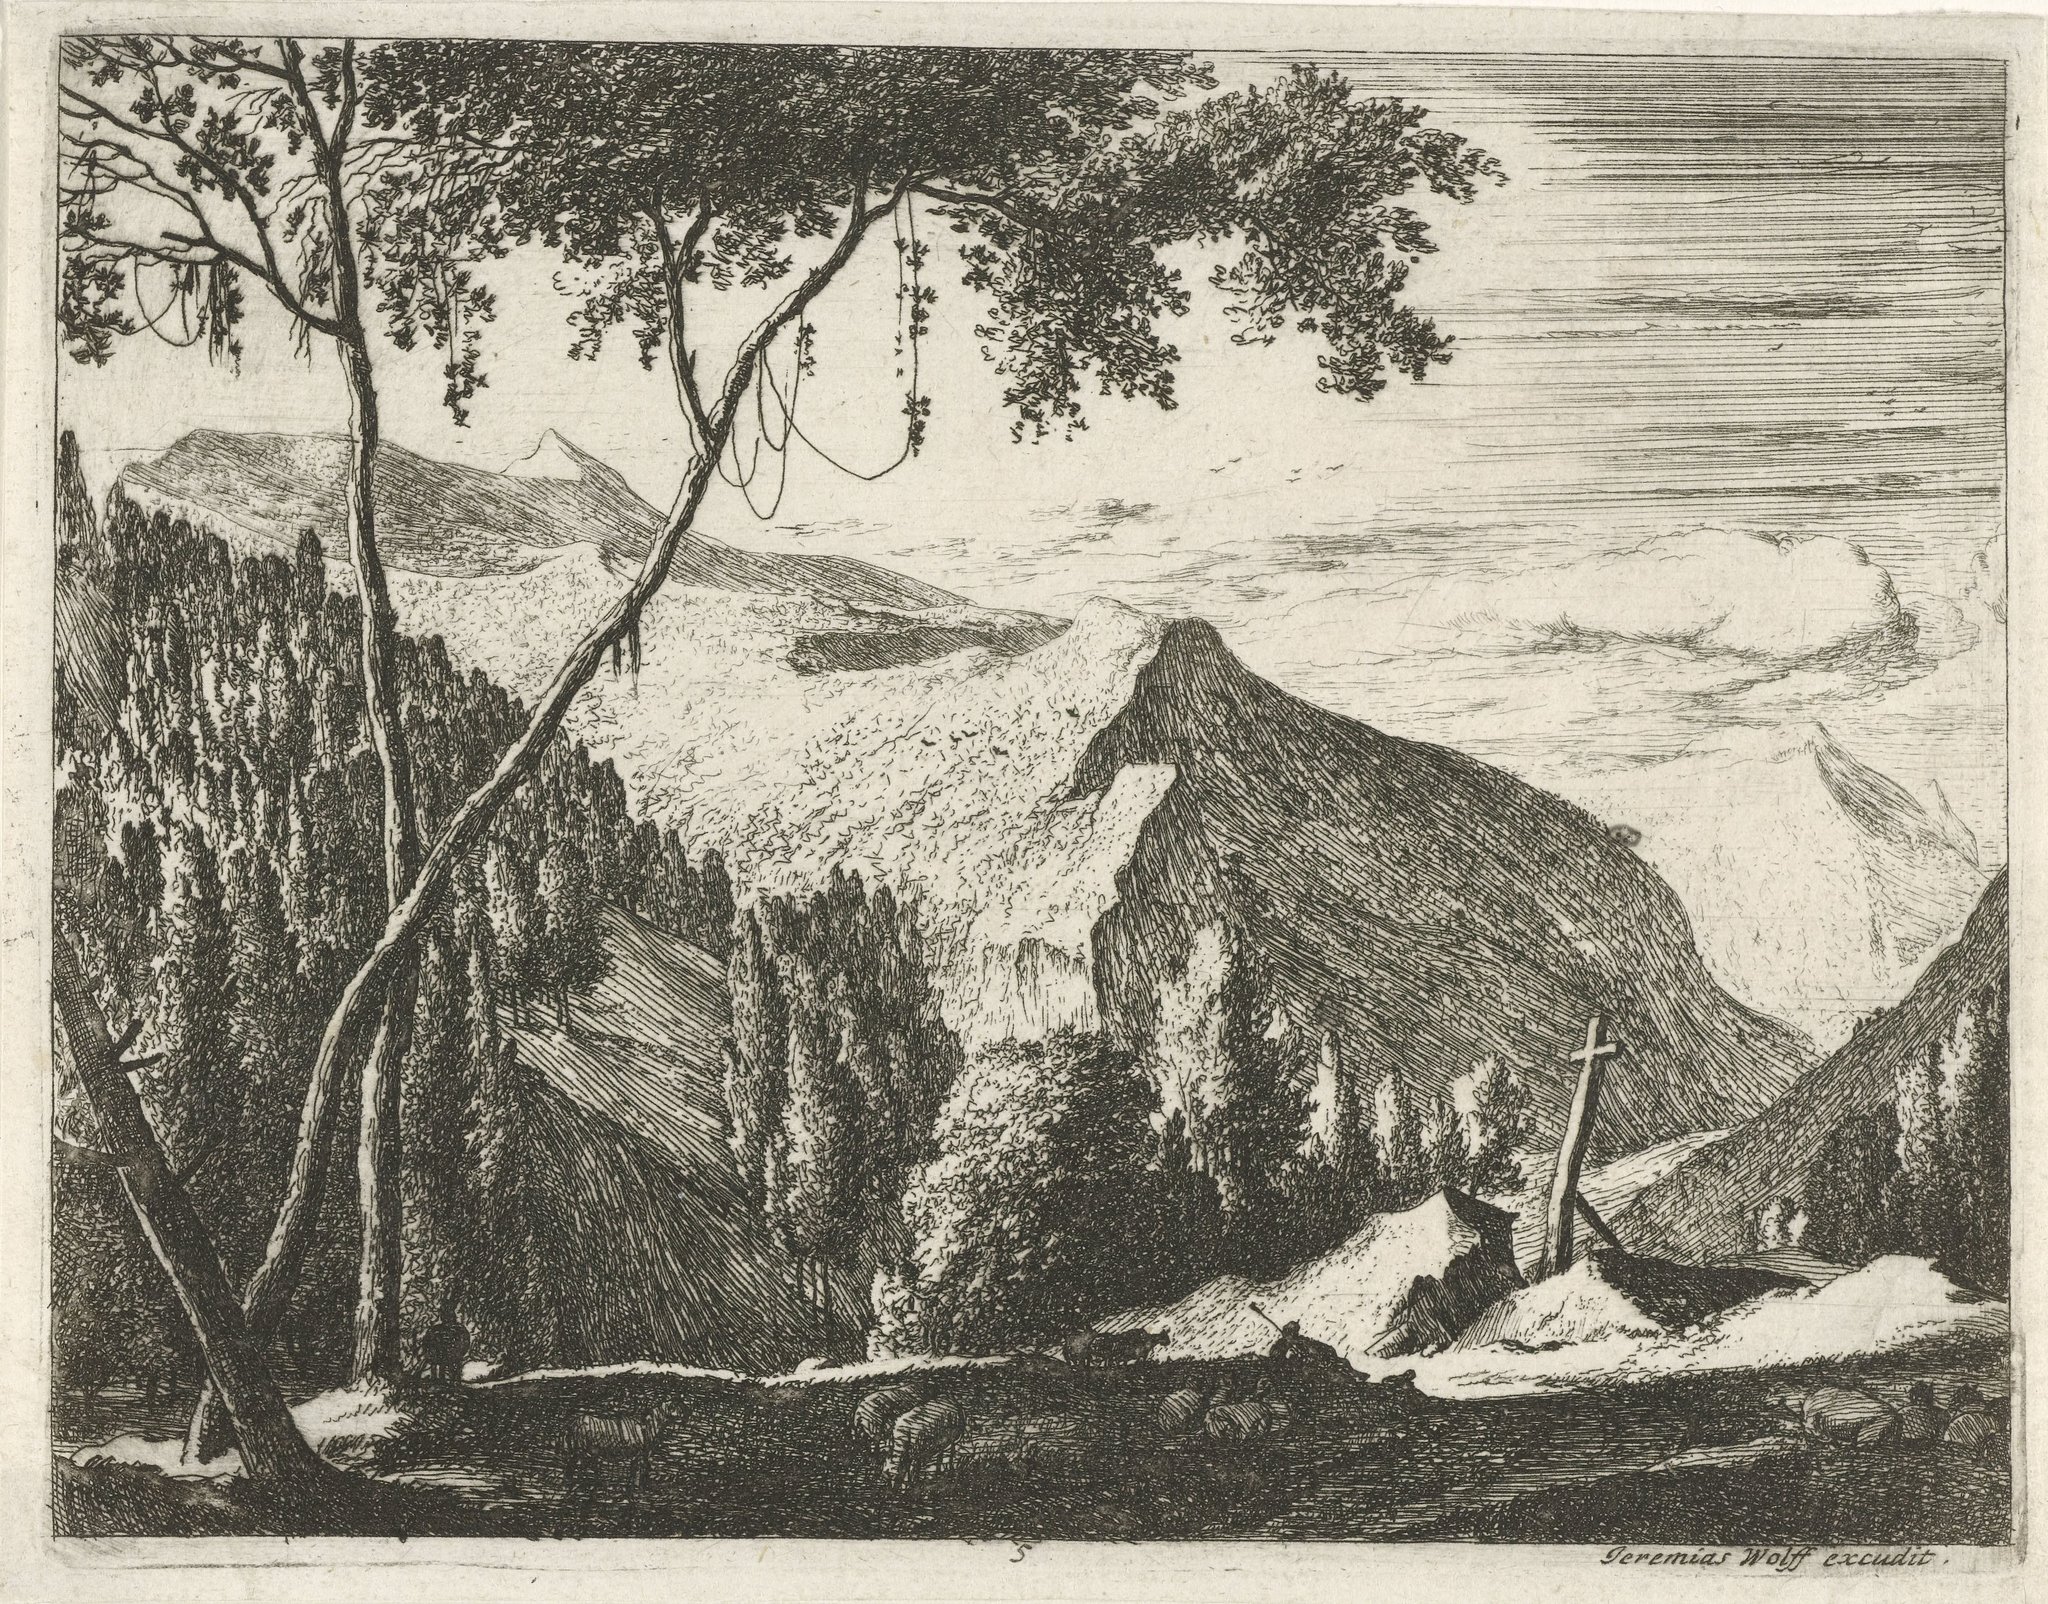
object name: print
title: Berglandschap met kruis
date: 1673-1724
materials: paper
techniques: etching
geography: amsterdam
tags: other kinds of grave-markers, e.g. cross, herd, flock, mountains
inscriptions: collector's mark: Lugt 2228a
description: Gezicht op een kruis in een berglandschap, met op voorgrond een herder met zijn kudde. Prent uit een serie van acht prenten met Tiroolse landschappen.